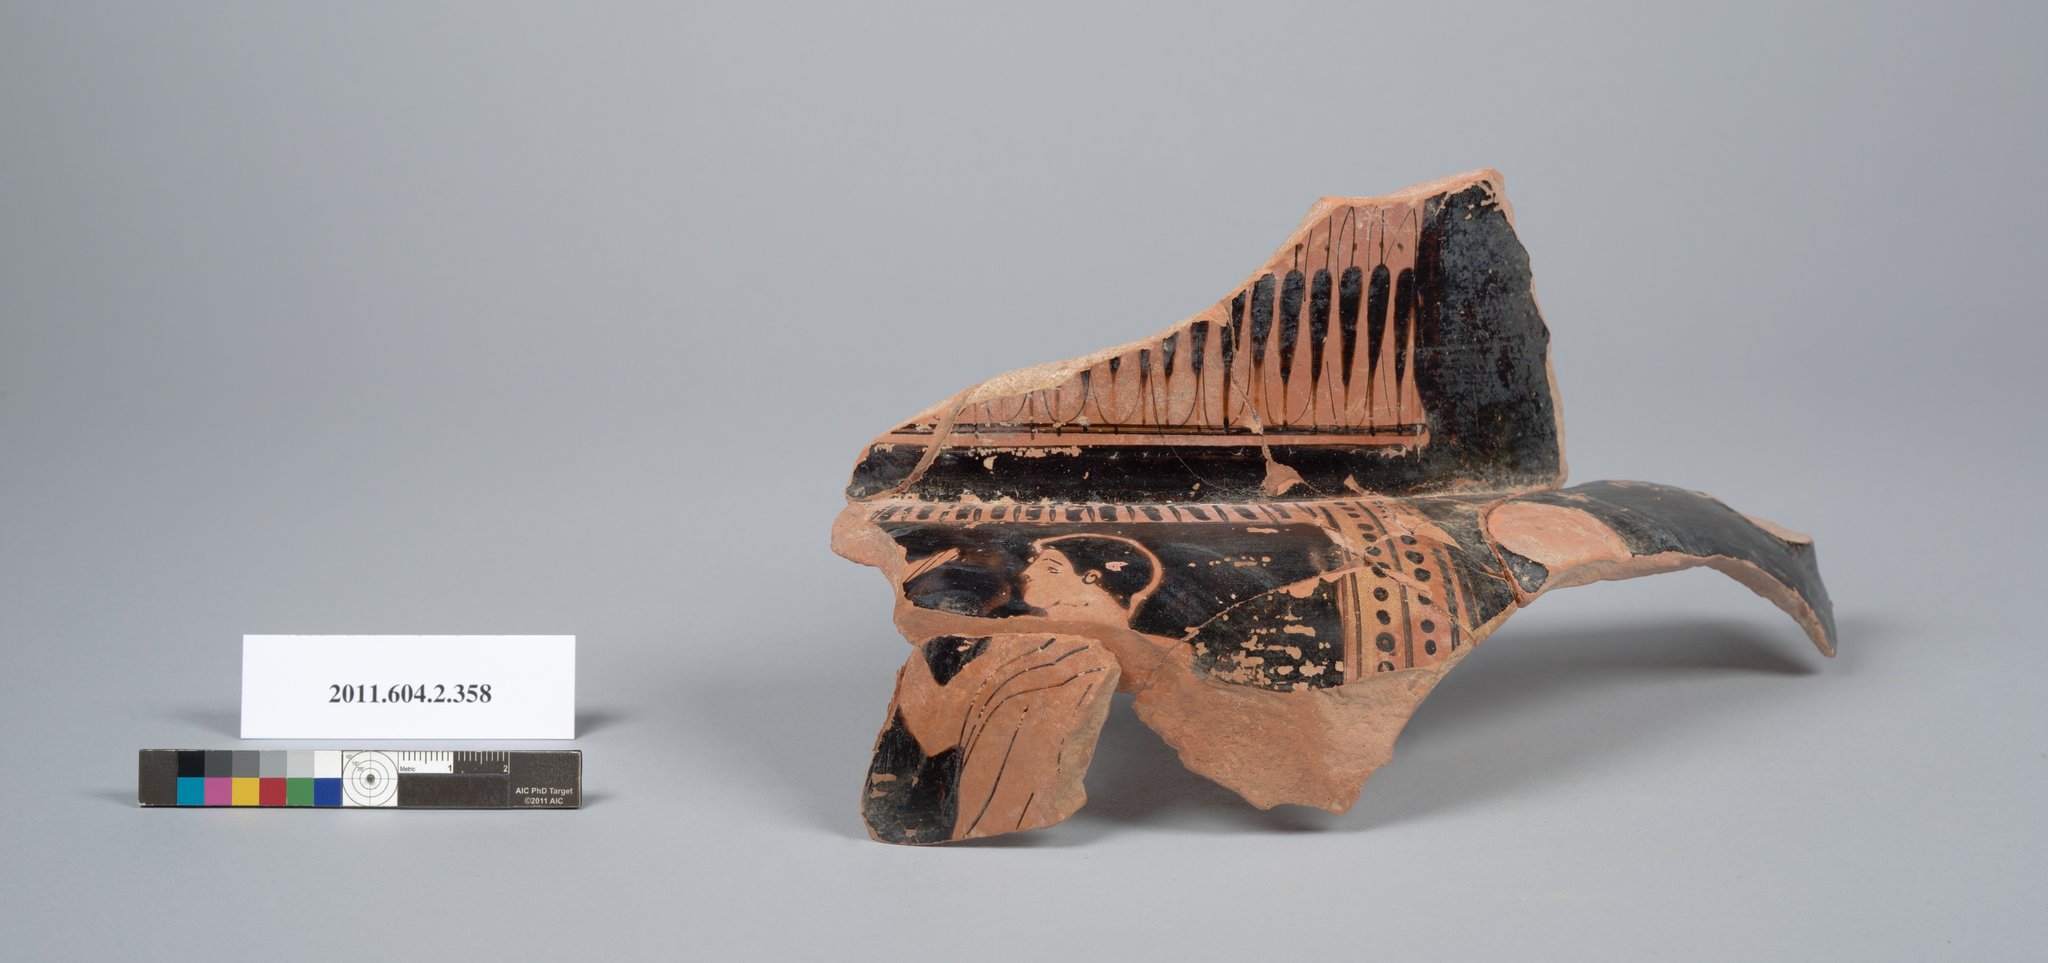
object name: column krater fragment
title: Terracotta fragment of a column-krater (bowl for mixing wine and water)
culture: greek, attic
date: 440-430 BCE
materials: terracotta